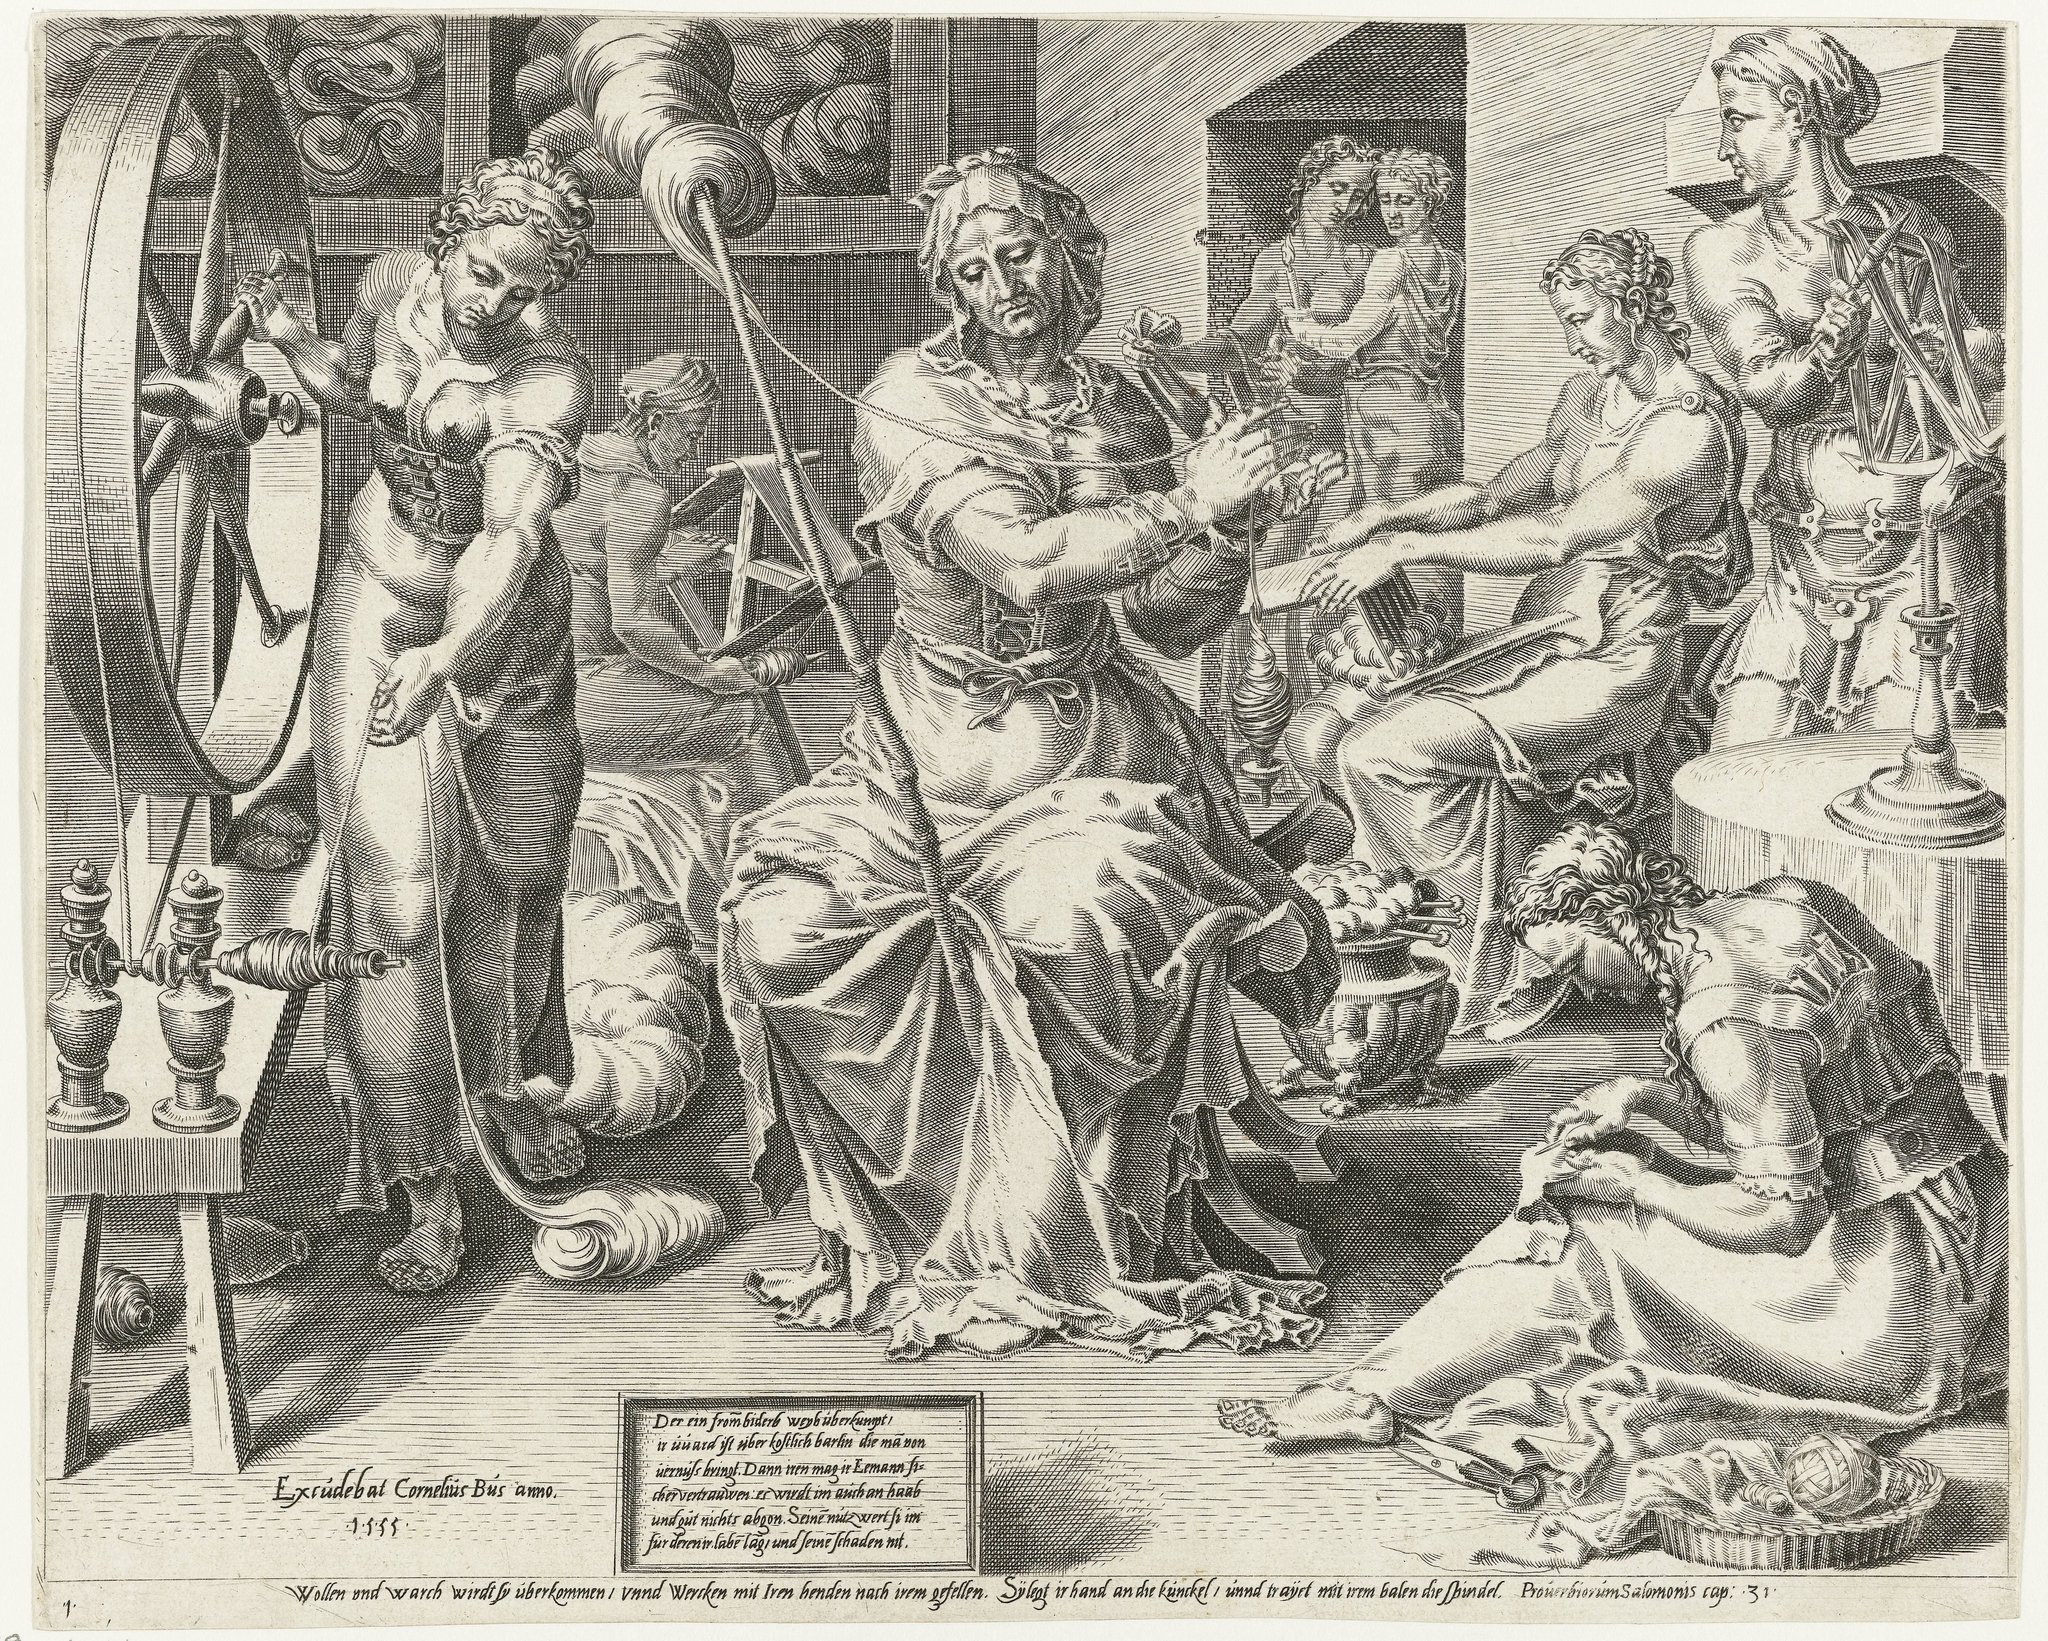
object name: print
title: Lof op de Deugdzame Huisvrouw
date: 1555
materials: paper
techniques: engraving, etching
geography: groningen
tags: ideal wife, flax (material ~ textile industry) (+ basic industrial processes), spinning-wheel (+ women (labourers)), the book of proverbs (with book chapter:verse)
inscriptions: collector's mark: Lugt 2760, collector's mark: Lugt 2228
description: De deugdzame huisvrouw spint wol en linnen. Haar dienstmaagden helpen haar. De prent is gebaseerd op Spreuken 31:12: 'De deugdzame vrouw zoekt wol en linnen uit, en spint en weeft met vreugde'. De afbeelding heeft een Duits onderschrift en maakt deel uit van een zesdelige prentserie die de bezigheden van de deugdzame huisvrouw looft.